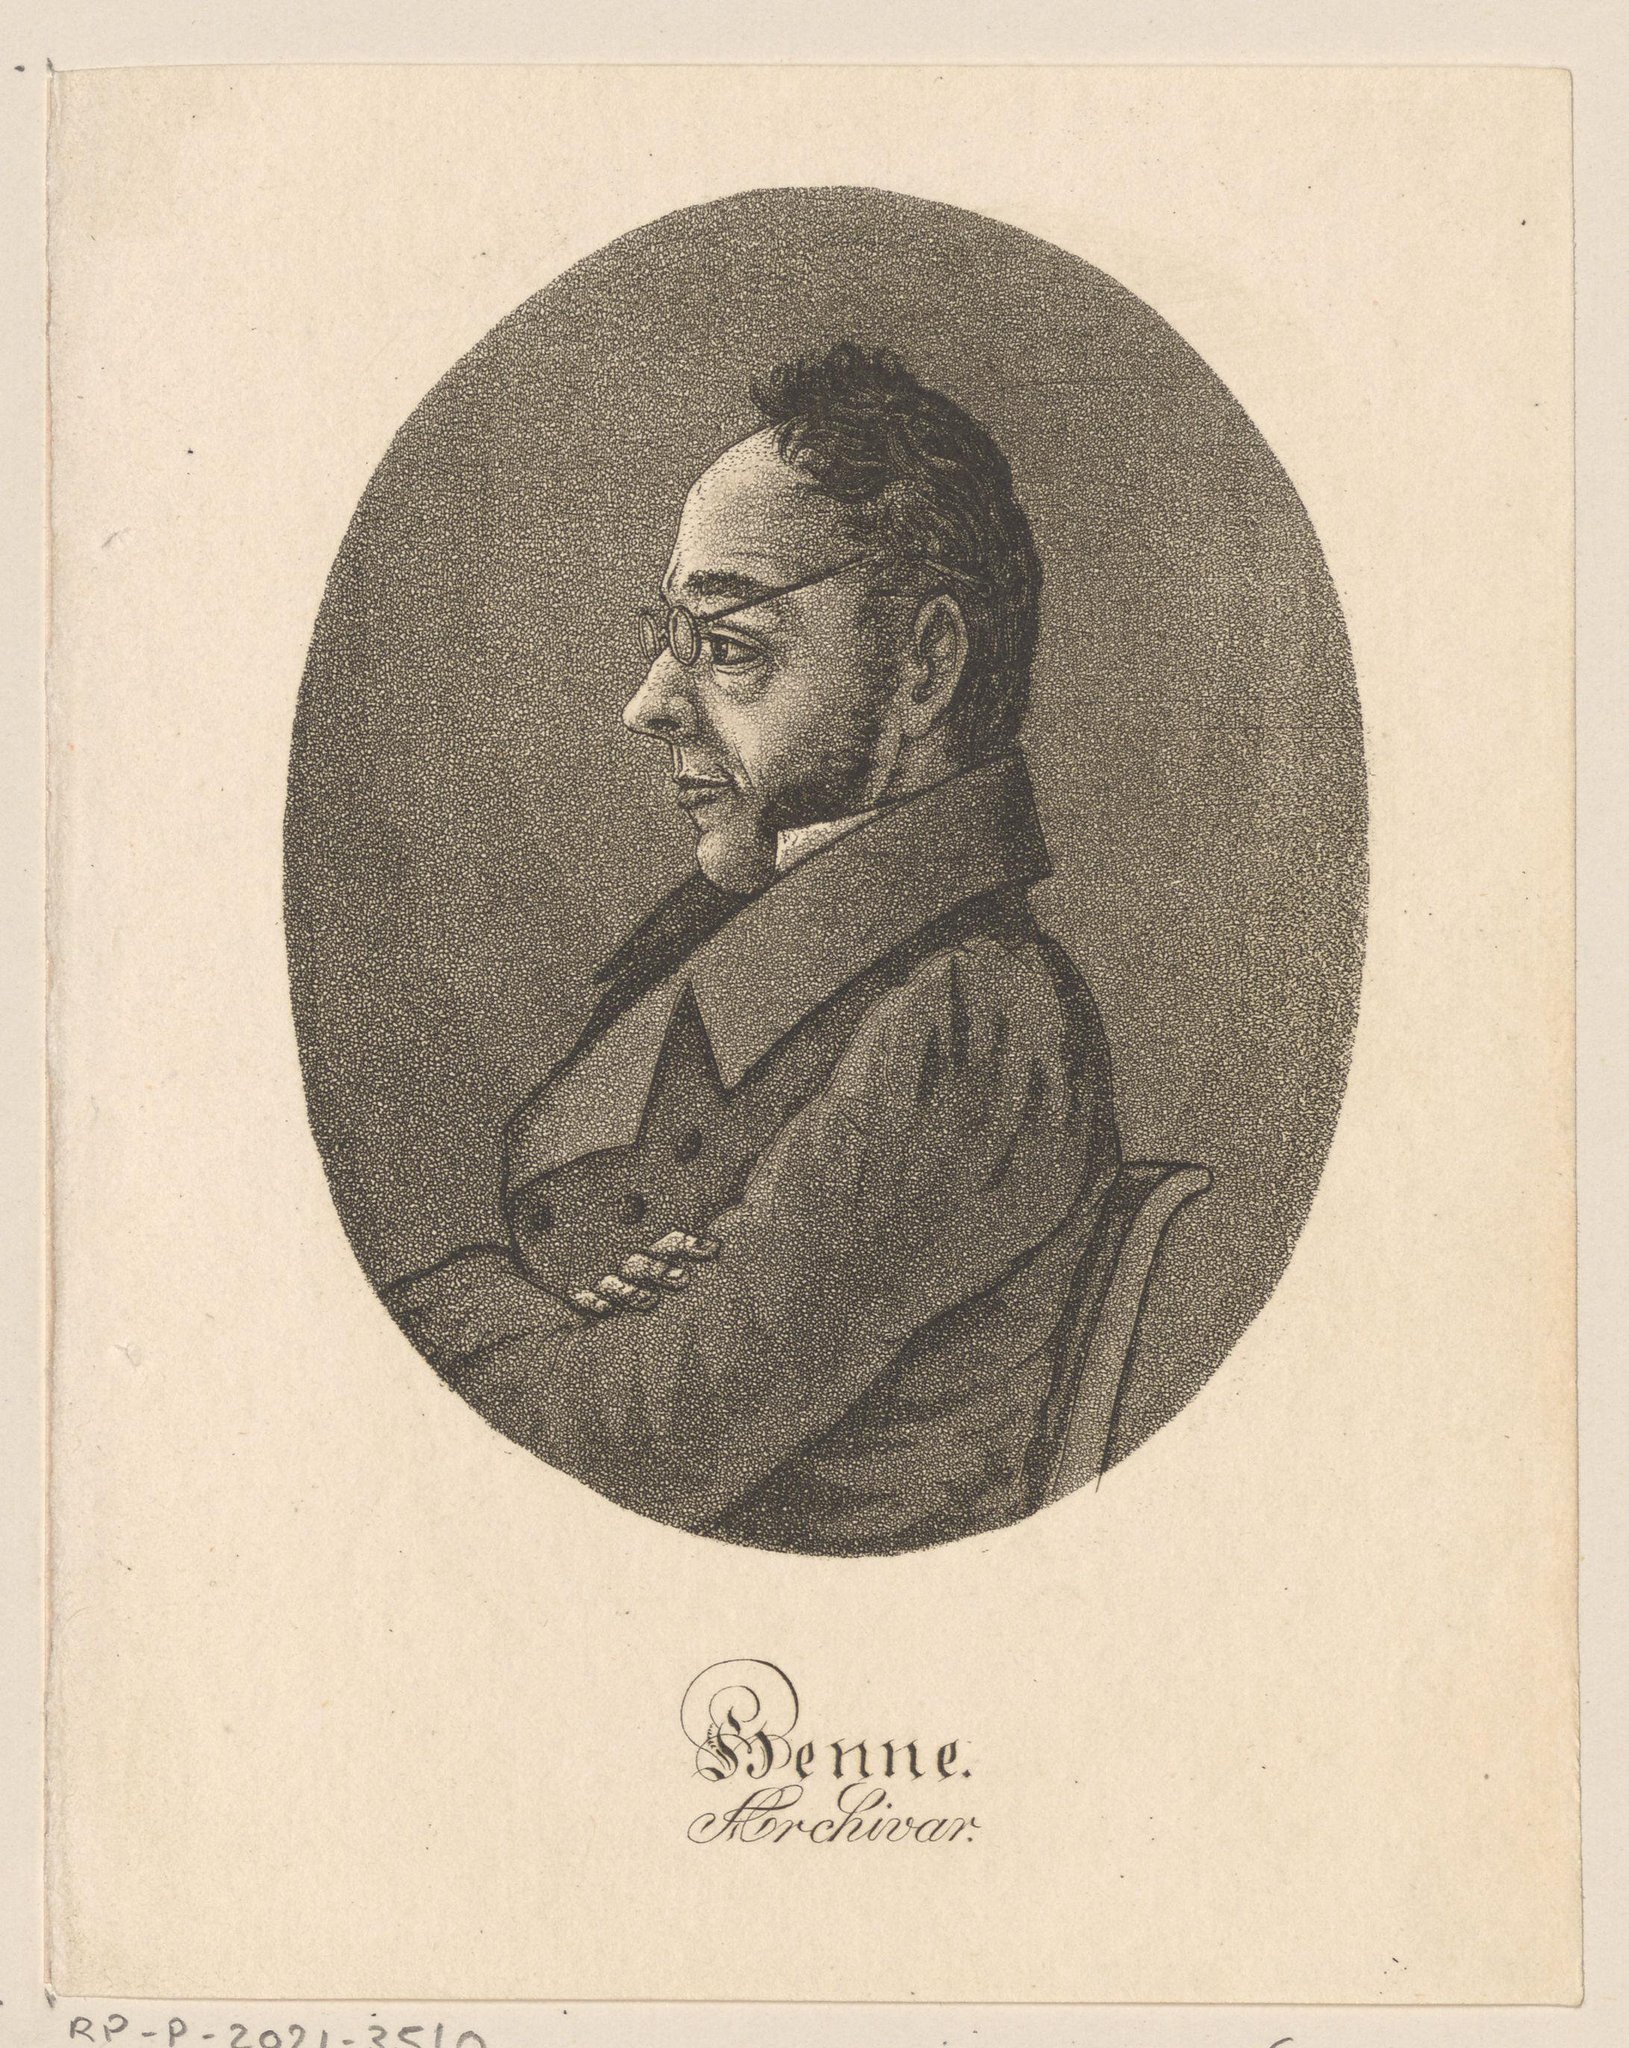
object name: print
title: Portret van Anton Henne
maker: Anonymous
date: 1826-1849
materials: paper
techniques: aquatint, engraving, etching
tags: politician, eyeglasses, spectacles, historical persons, portrait of a writer